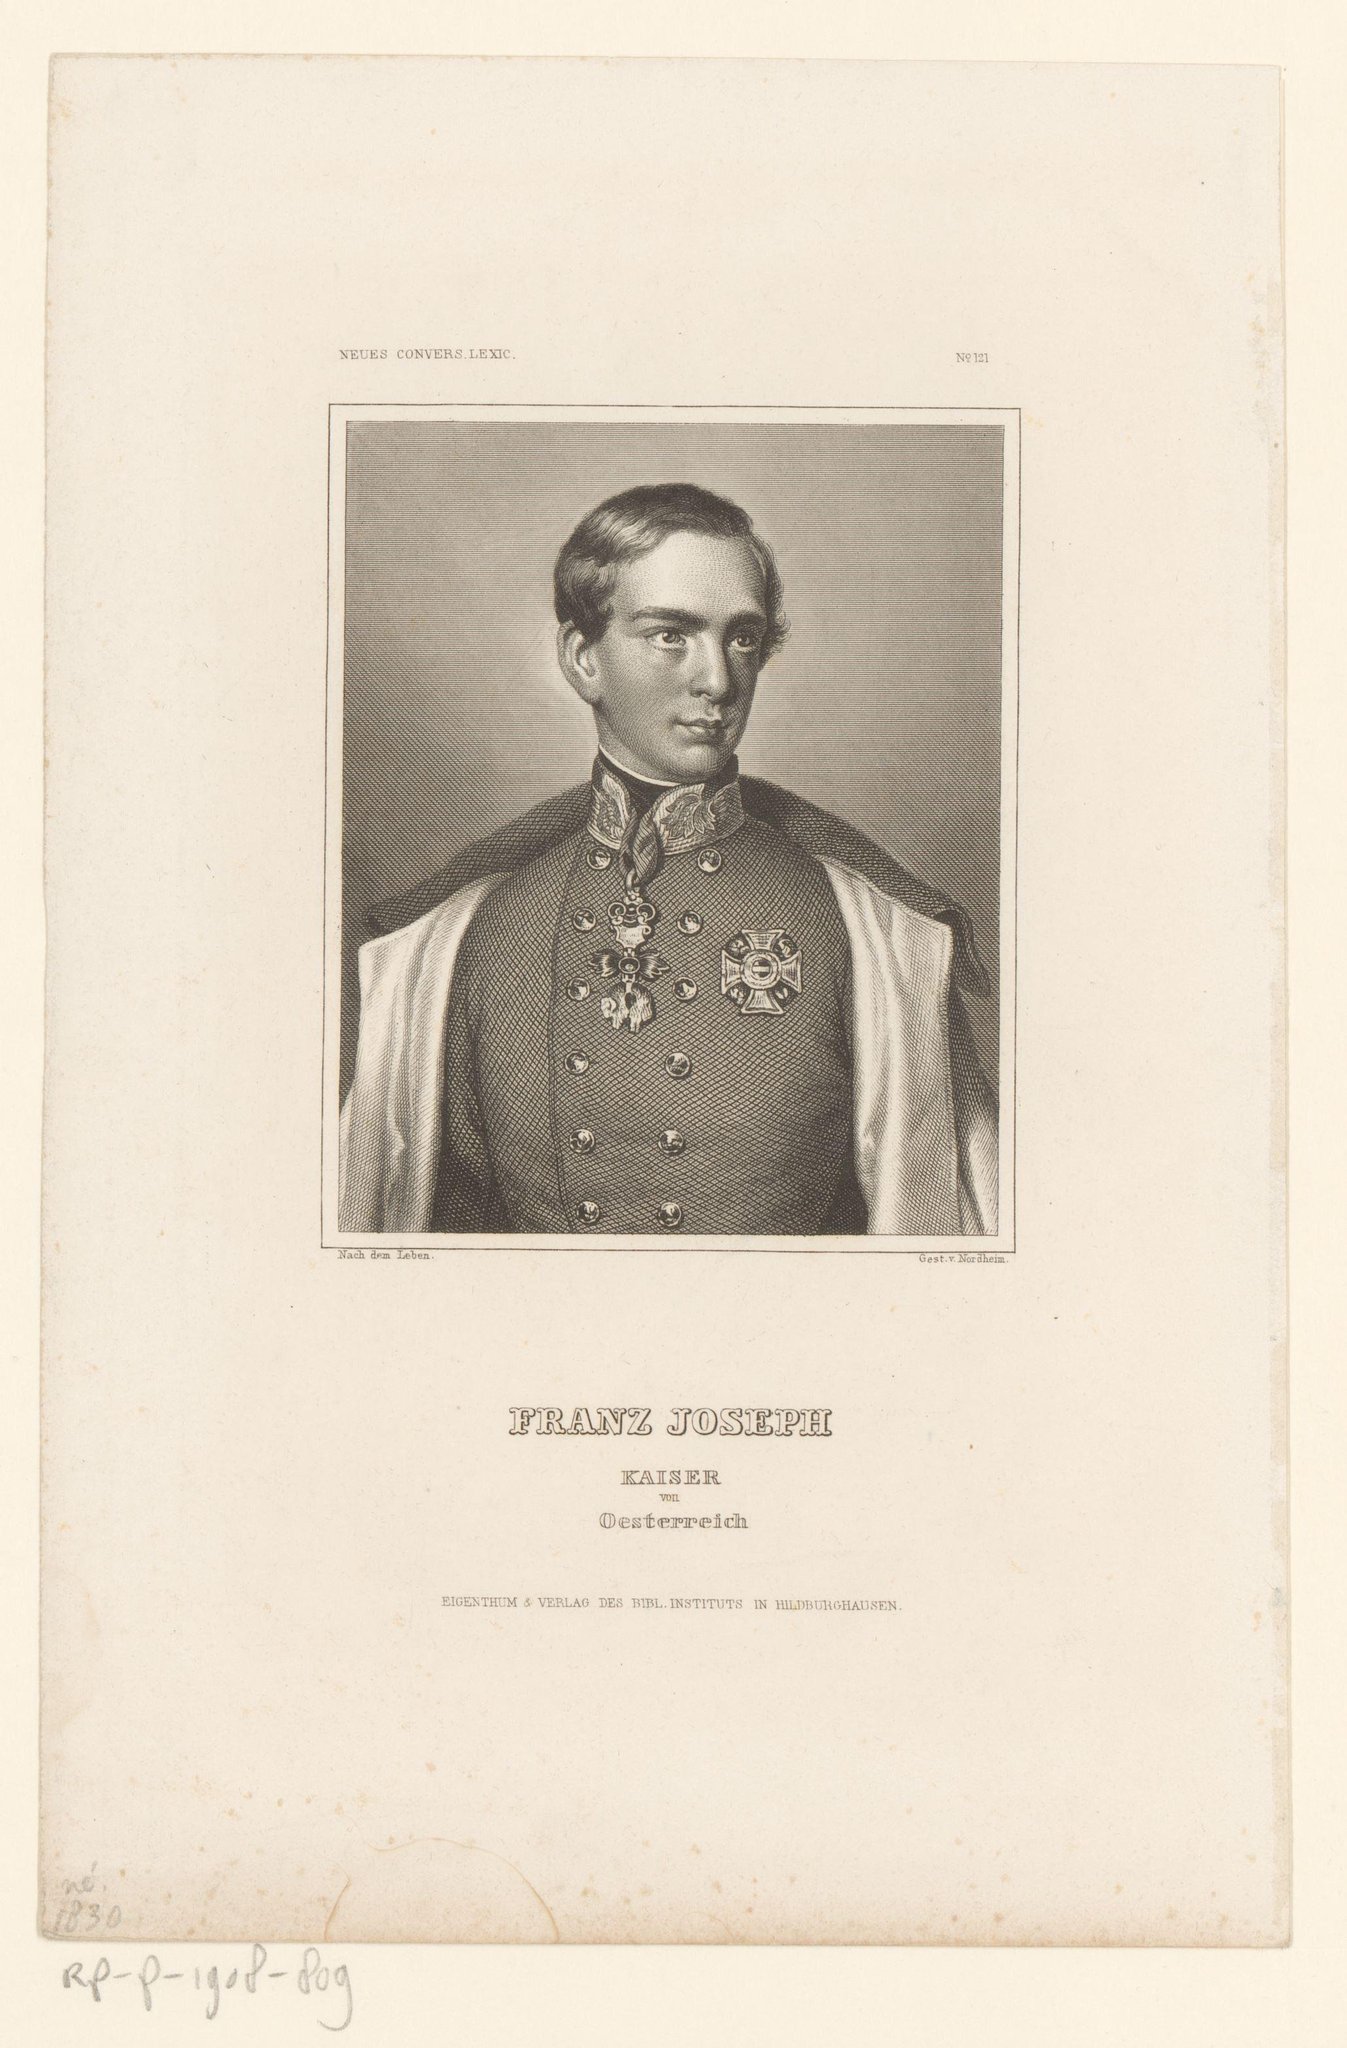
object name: print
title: Portret van Frans Jozef I Karel, keizer van Oostenrijk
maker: johann georg nordheim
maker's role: print maker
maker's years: 1804-1853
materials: paper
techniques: engraving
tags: historical persons, medals and other marks of military honour, knighthood order of the golden fleece - insignia of a knighthood order, e.g.: badge, chain (with name of order)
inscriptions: collector's mark: Lugt 2228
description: Prent afkomstig uit: Neues Konversations-Lexikon, ein Wörterbuch des allgemeinen Wissens, voor het eerst uitgegeven tussen 1861-1867.